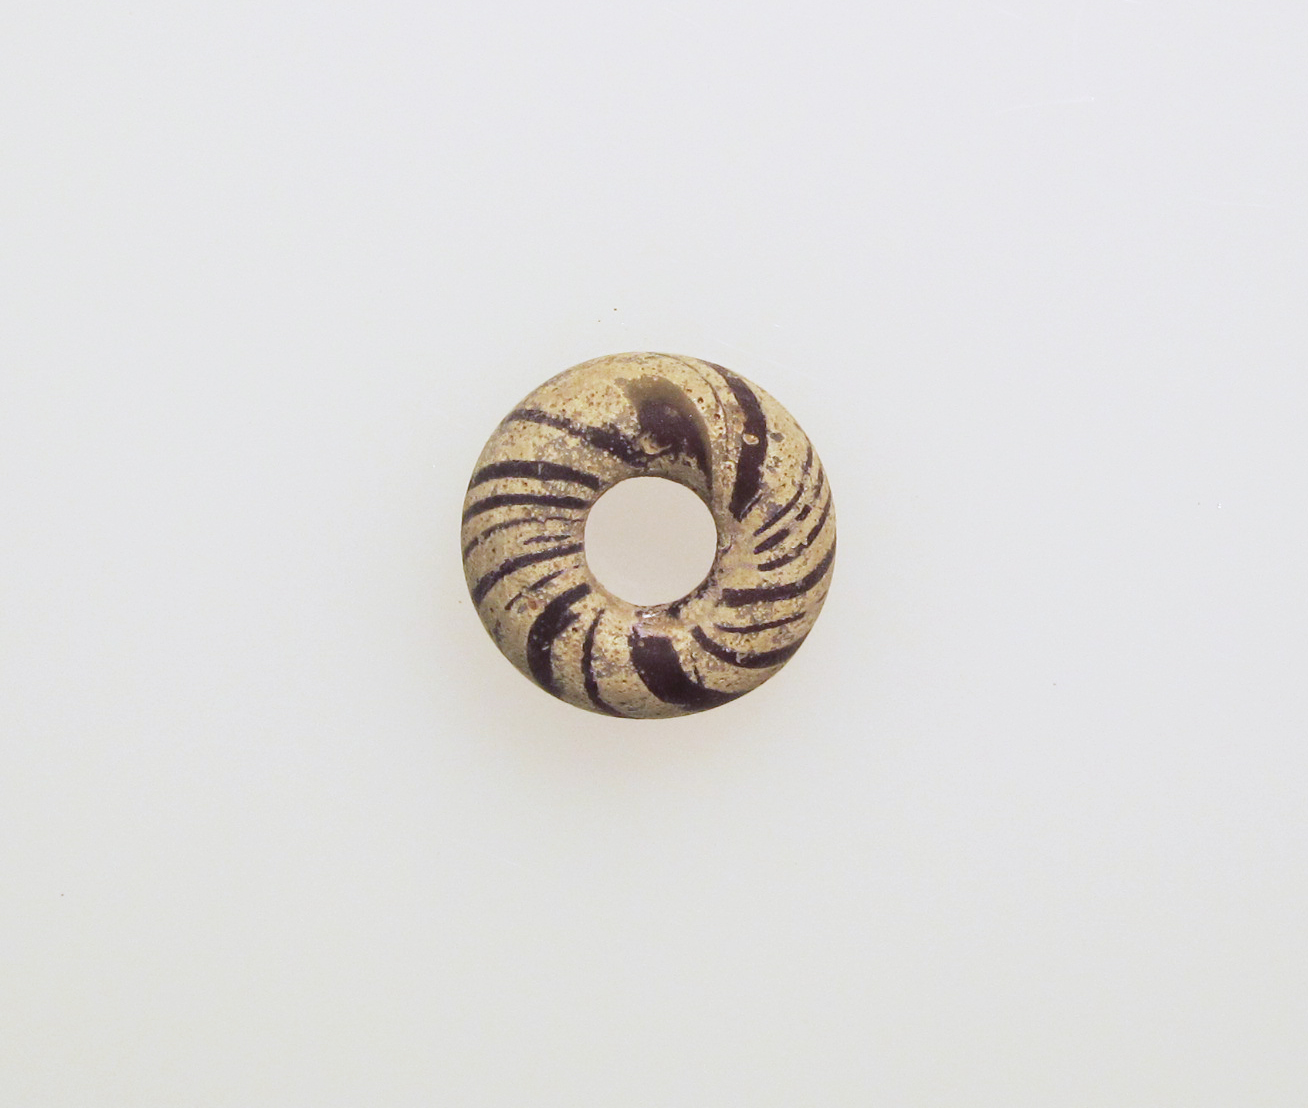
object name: bead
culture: roman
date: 670 BCE-330 CE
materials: glass